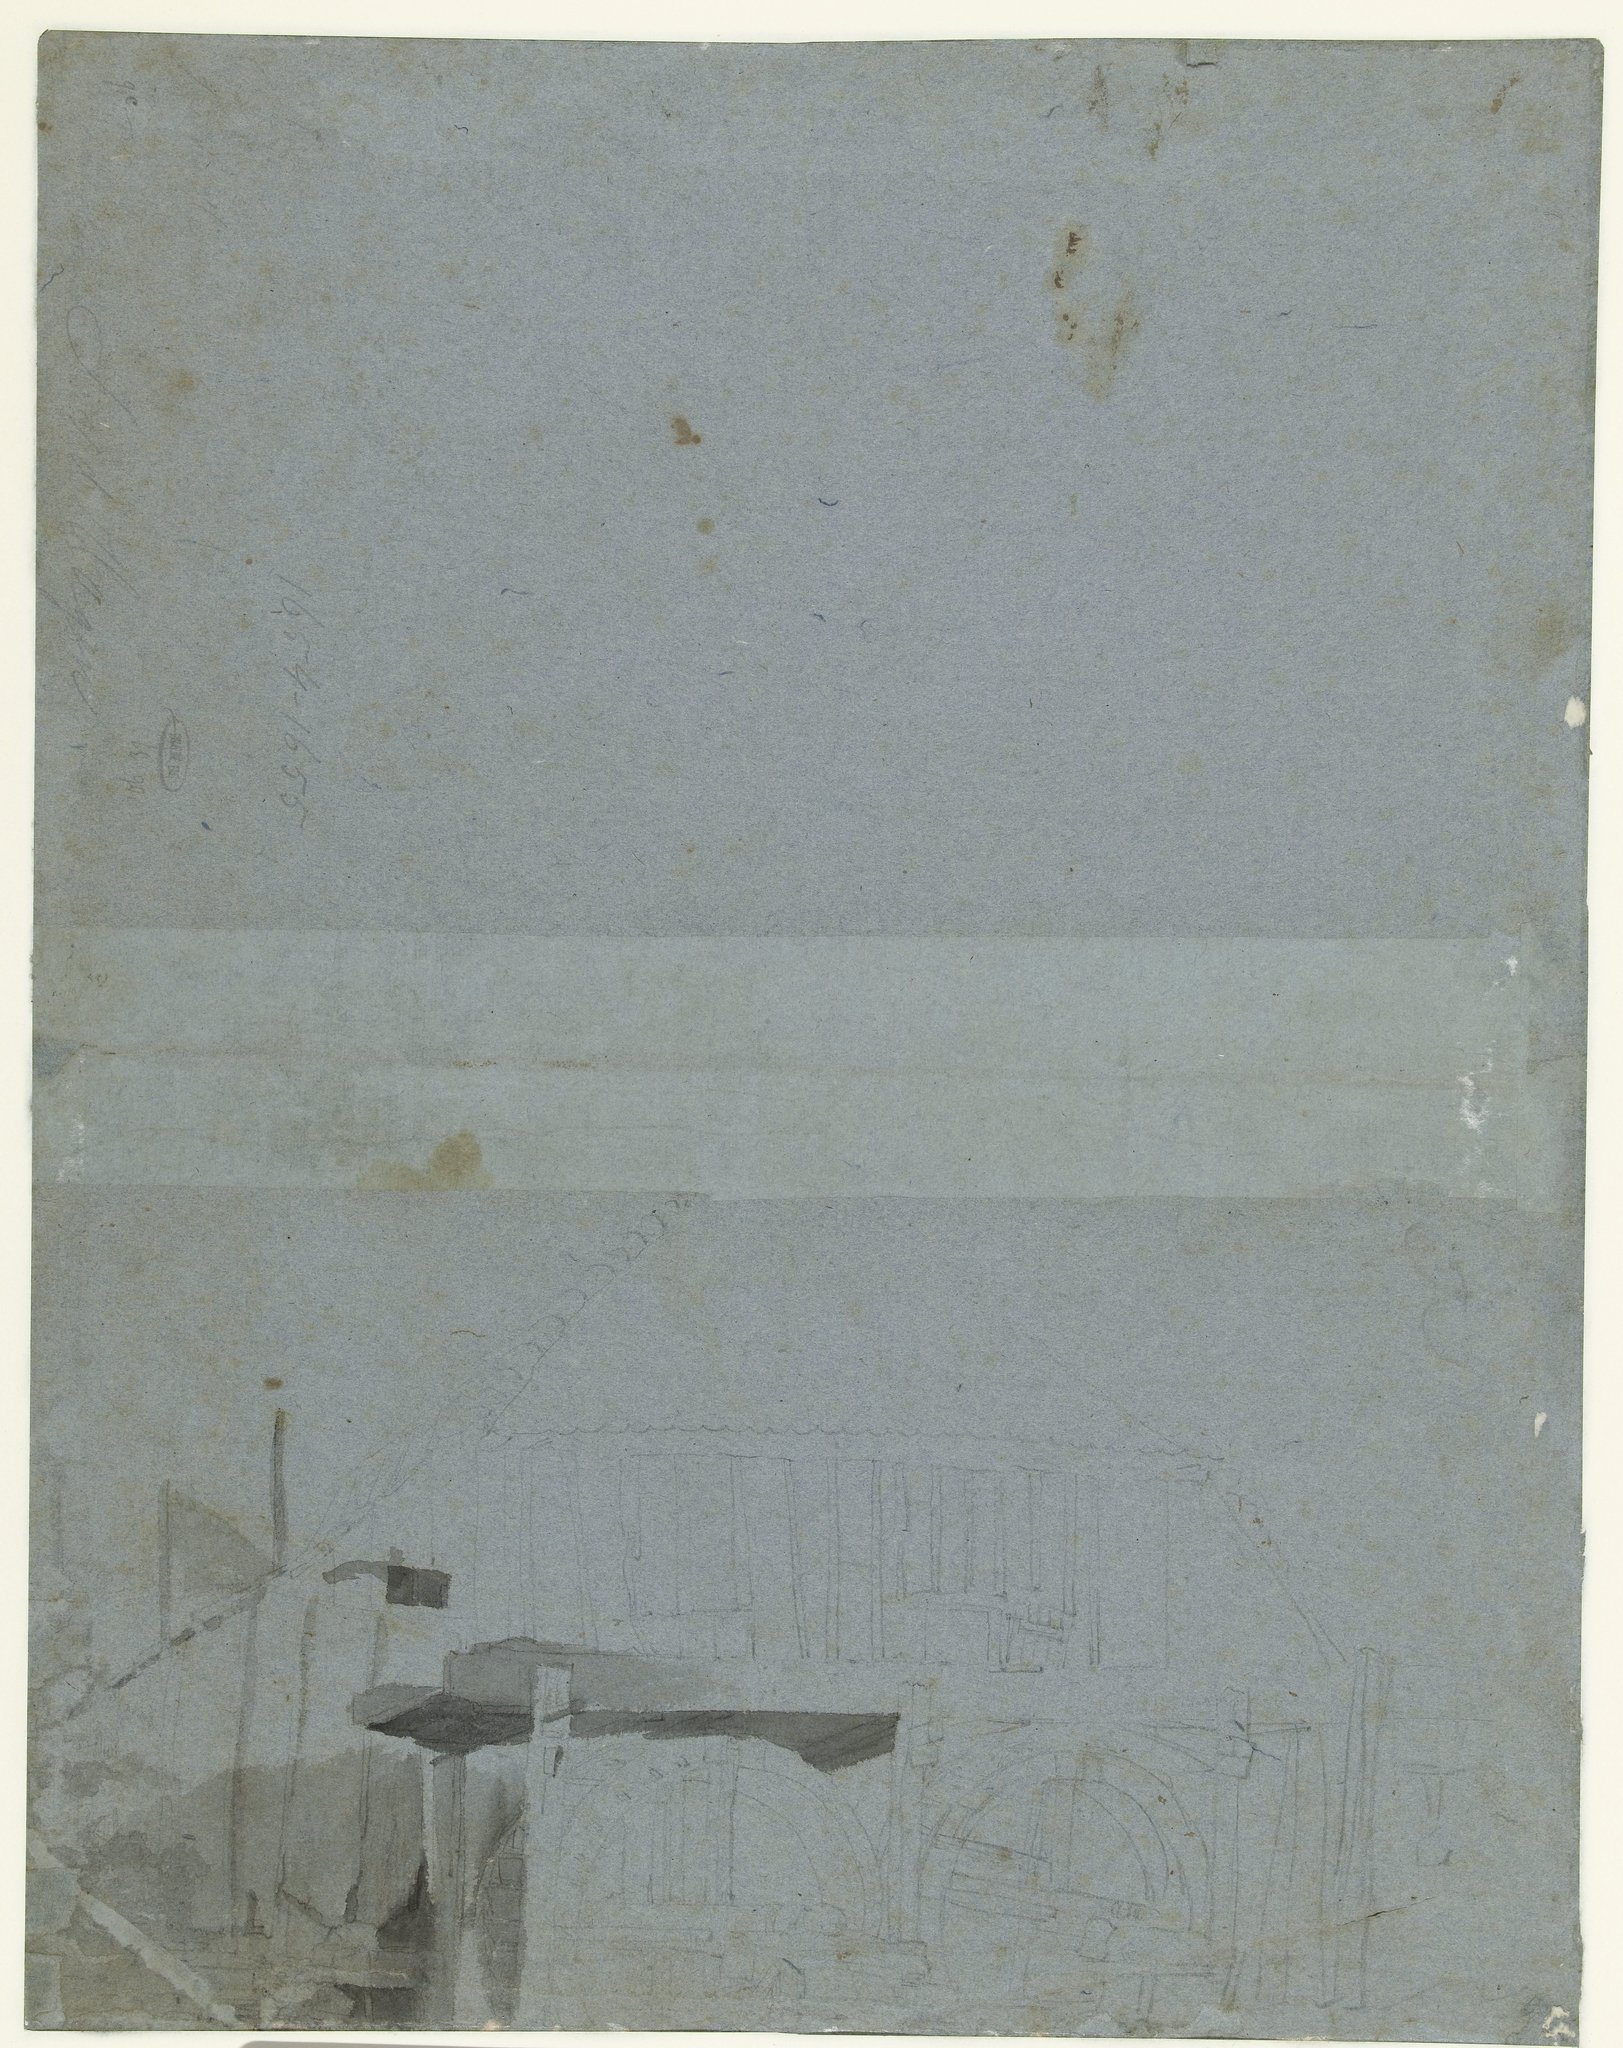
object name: drawing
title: Schets van een watermolen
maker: joris van der haagen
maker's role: draughtsman, painter, print maker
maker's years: 1615-1669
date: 1625-1669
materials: chalk, paper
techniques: brush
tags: watermill